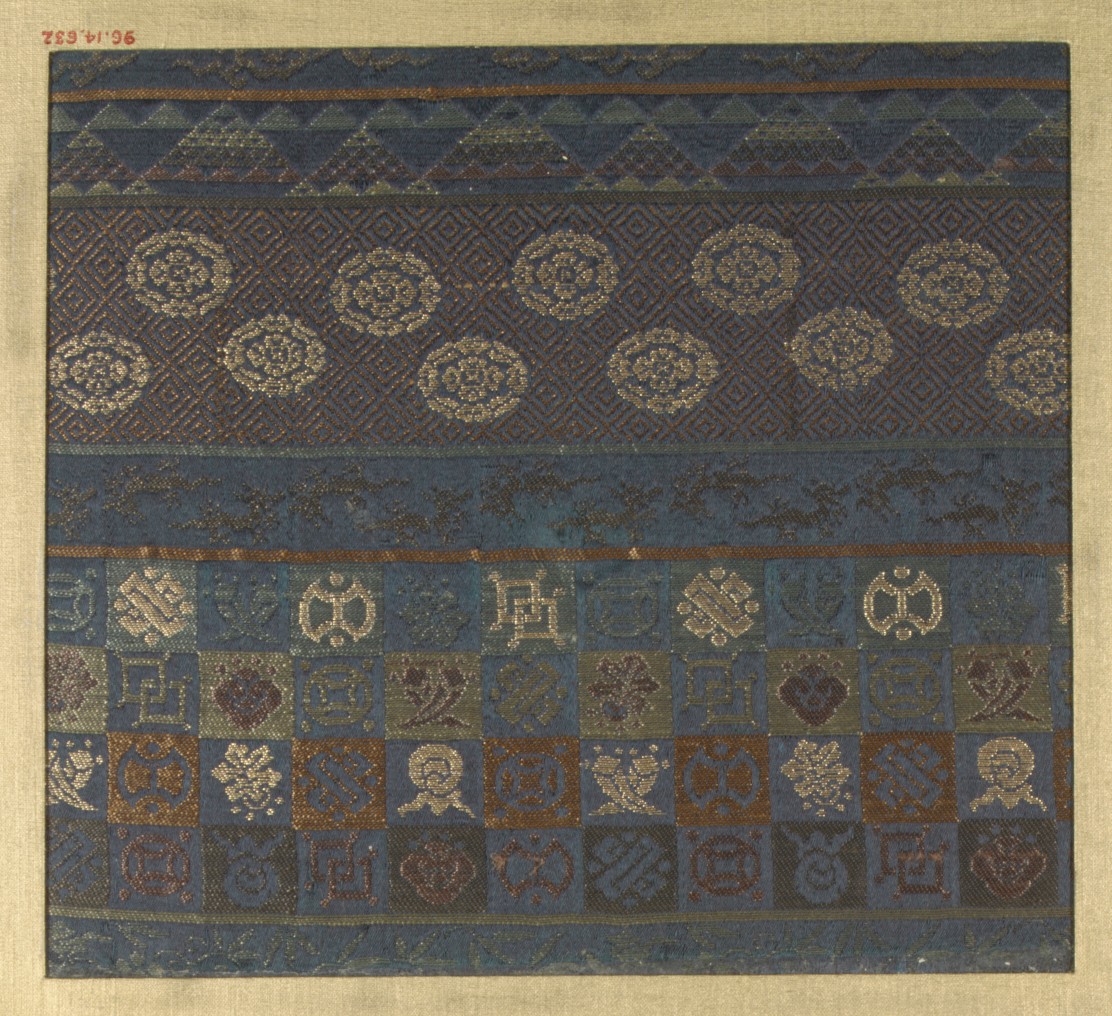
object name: piece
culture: japanese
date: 1701-1900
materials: silk